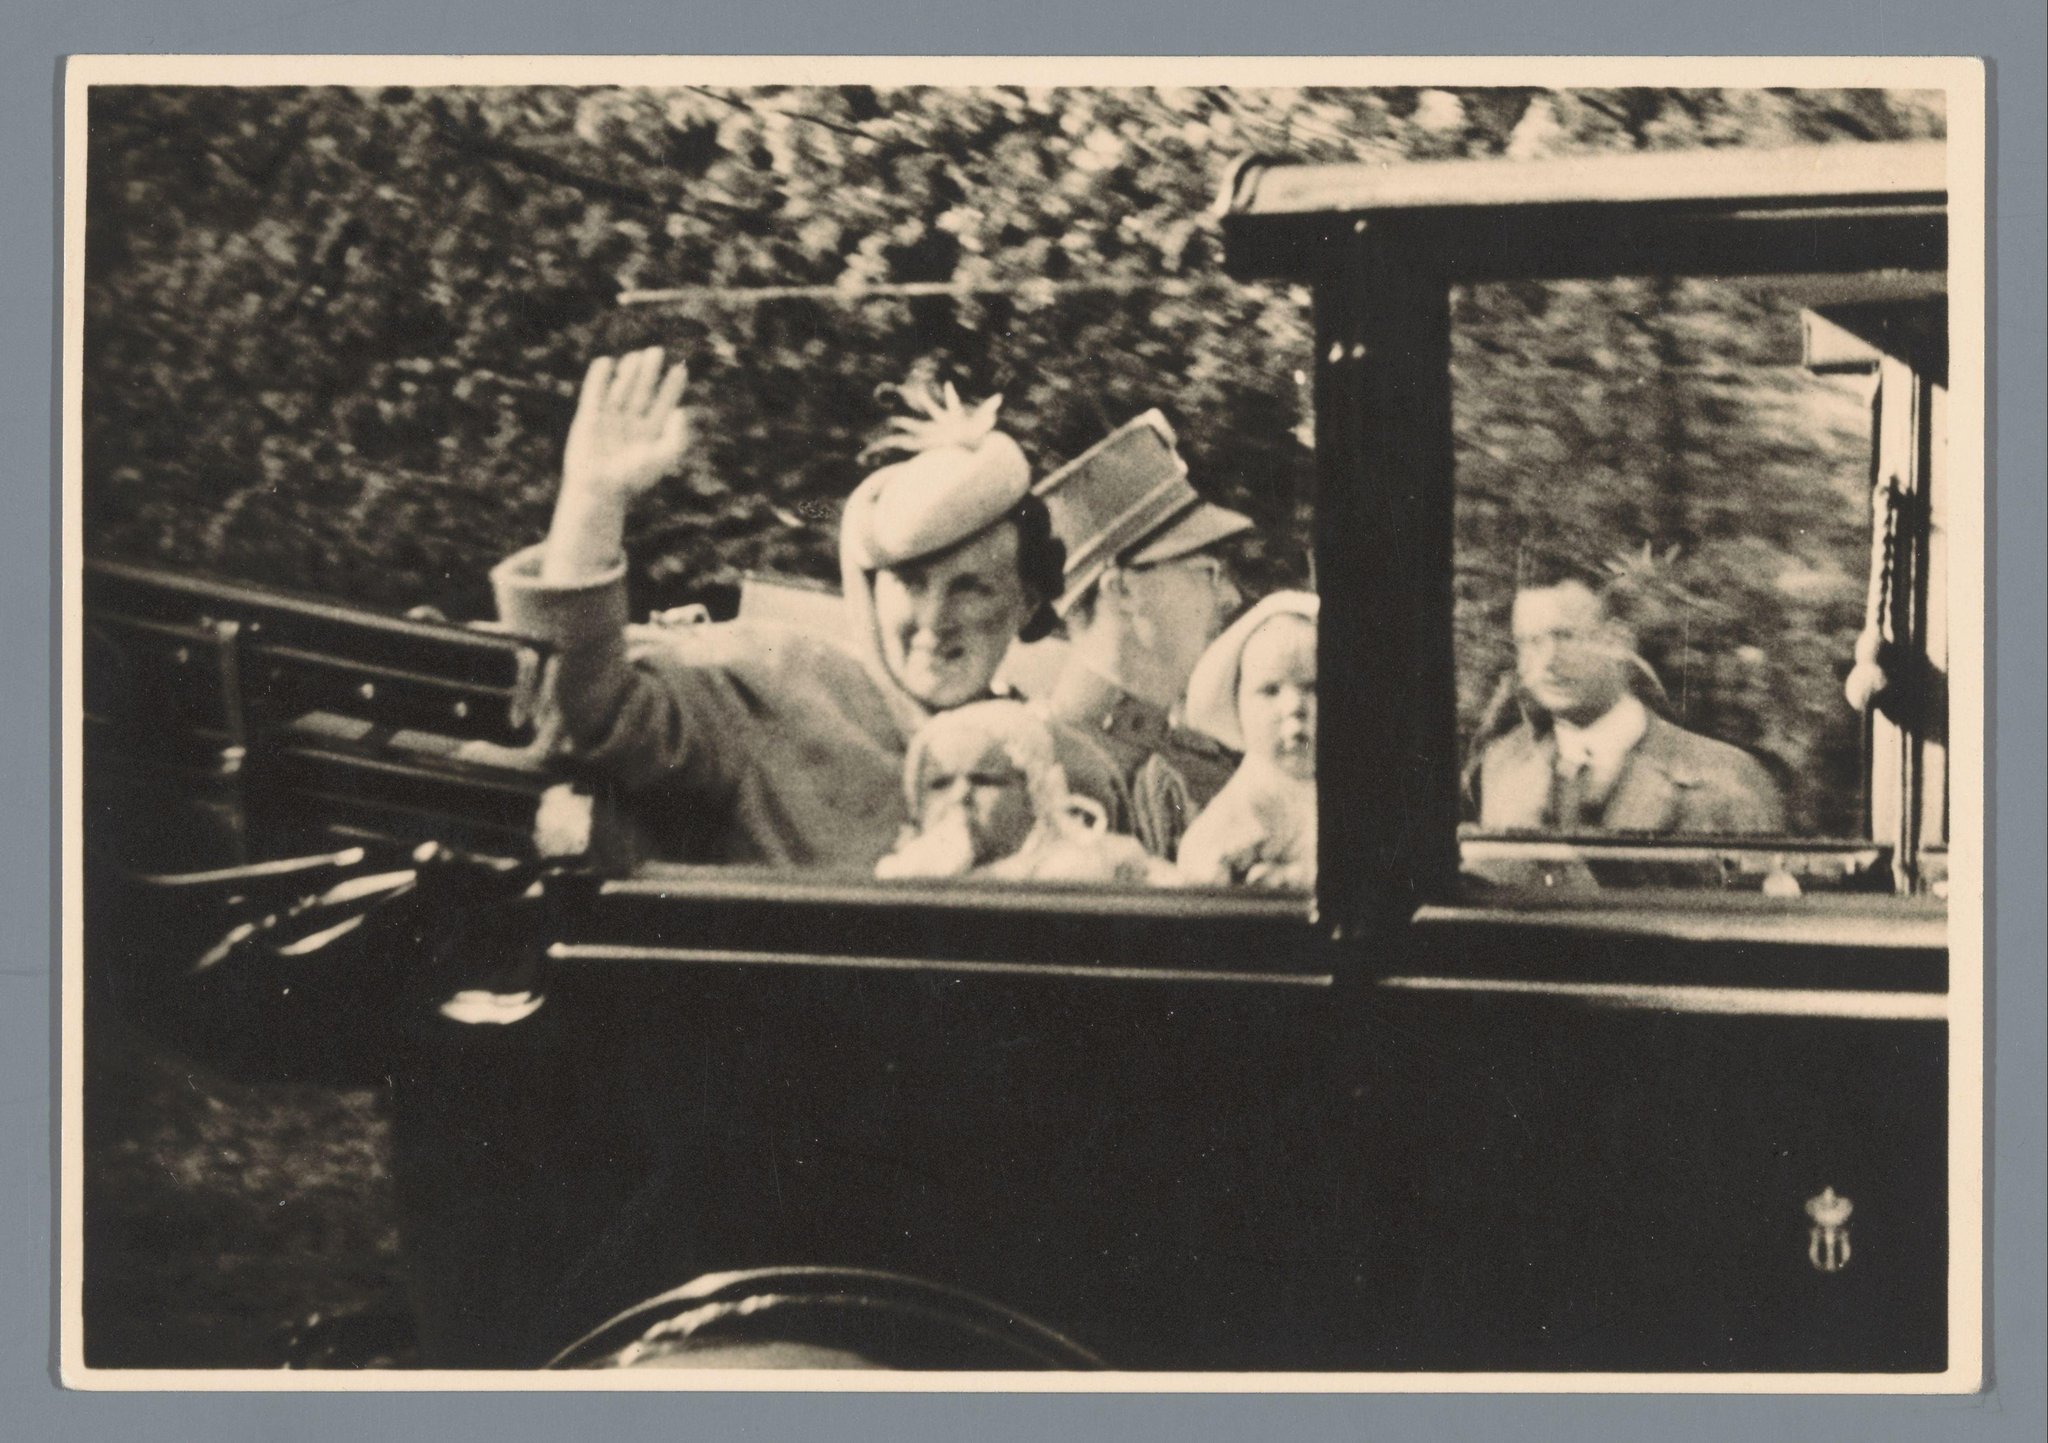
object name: photograph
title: 's Gravenhage, 30 April 1940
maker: Anonymous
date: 1940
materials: photographic support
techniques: gelatin silver print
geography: amsterdam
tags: utrecht, bernhard (prins der nederlanden), beatrix (koningin der nederlanden), the hague, juliana of the netherlands, family of the sovereign